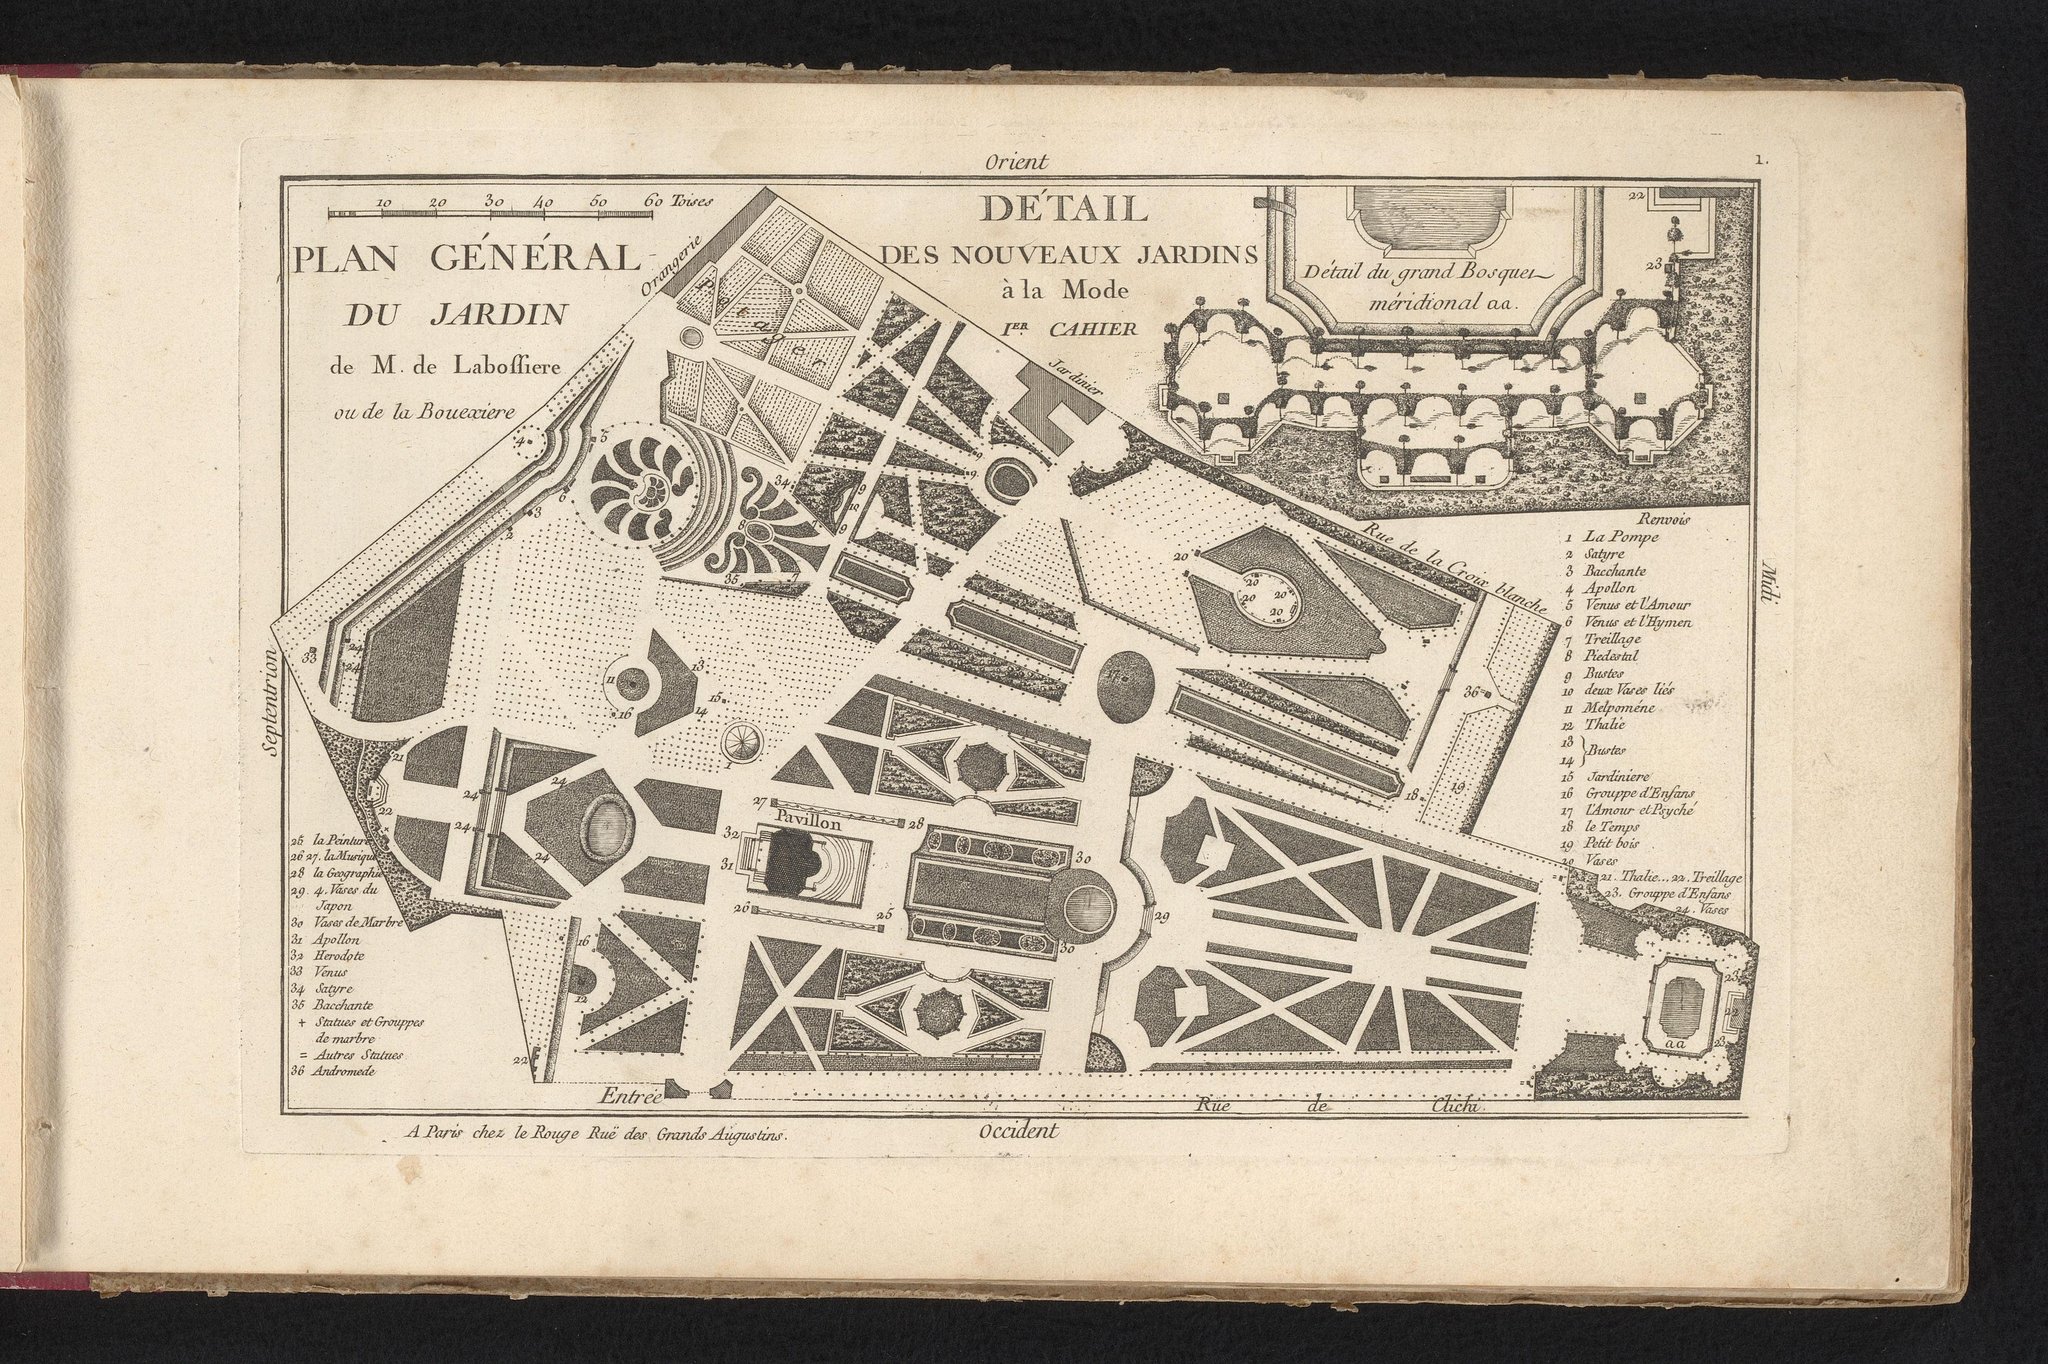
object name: titelprent, frontispice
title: Titelprent voor Jardins Anglo-Chinois, eerste cahier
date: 1775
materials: paper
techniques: engraving, etching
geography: france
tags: plan, map of garden, lay-out of garden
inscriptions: collector's mark: Lugt 2228, collector's mark: Lugt 2760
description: De serie 'Jardins anglo-chinois à la mode' verscheen in totaal in 21 zogeheten 'cahiers' (afleveringen). De huidige prent komt uit het eerste 'cahier'. Het Rijksmuseum Amsterdam bezit drie banden met daarin in totaal zes 'cahiers' van deze reeks. In de documentatie wordt verwezen naar een in de bibliotheek van het Rijksmuseum Amsterdam aanwezige facsimile van het complete werk.